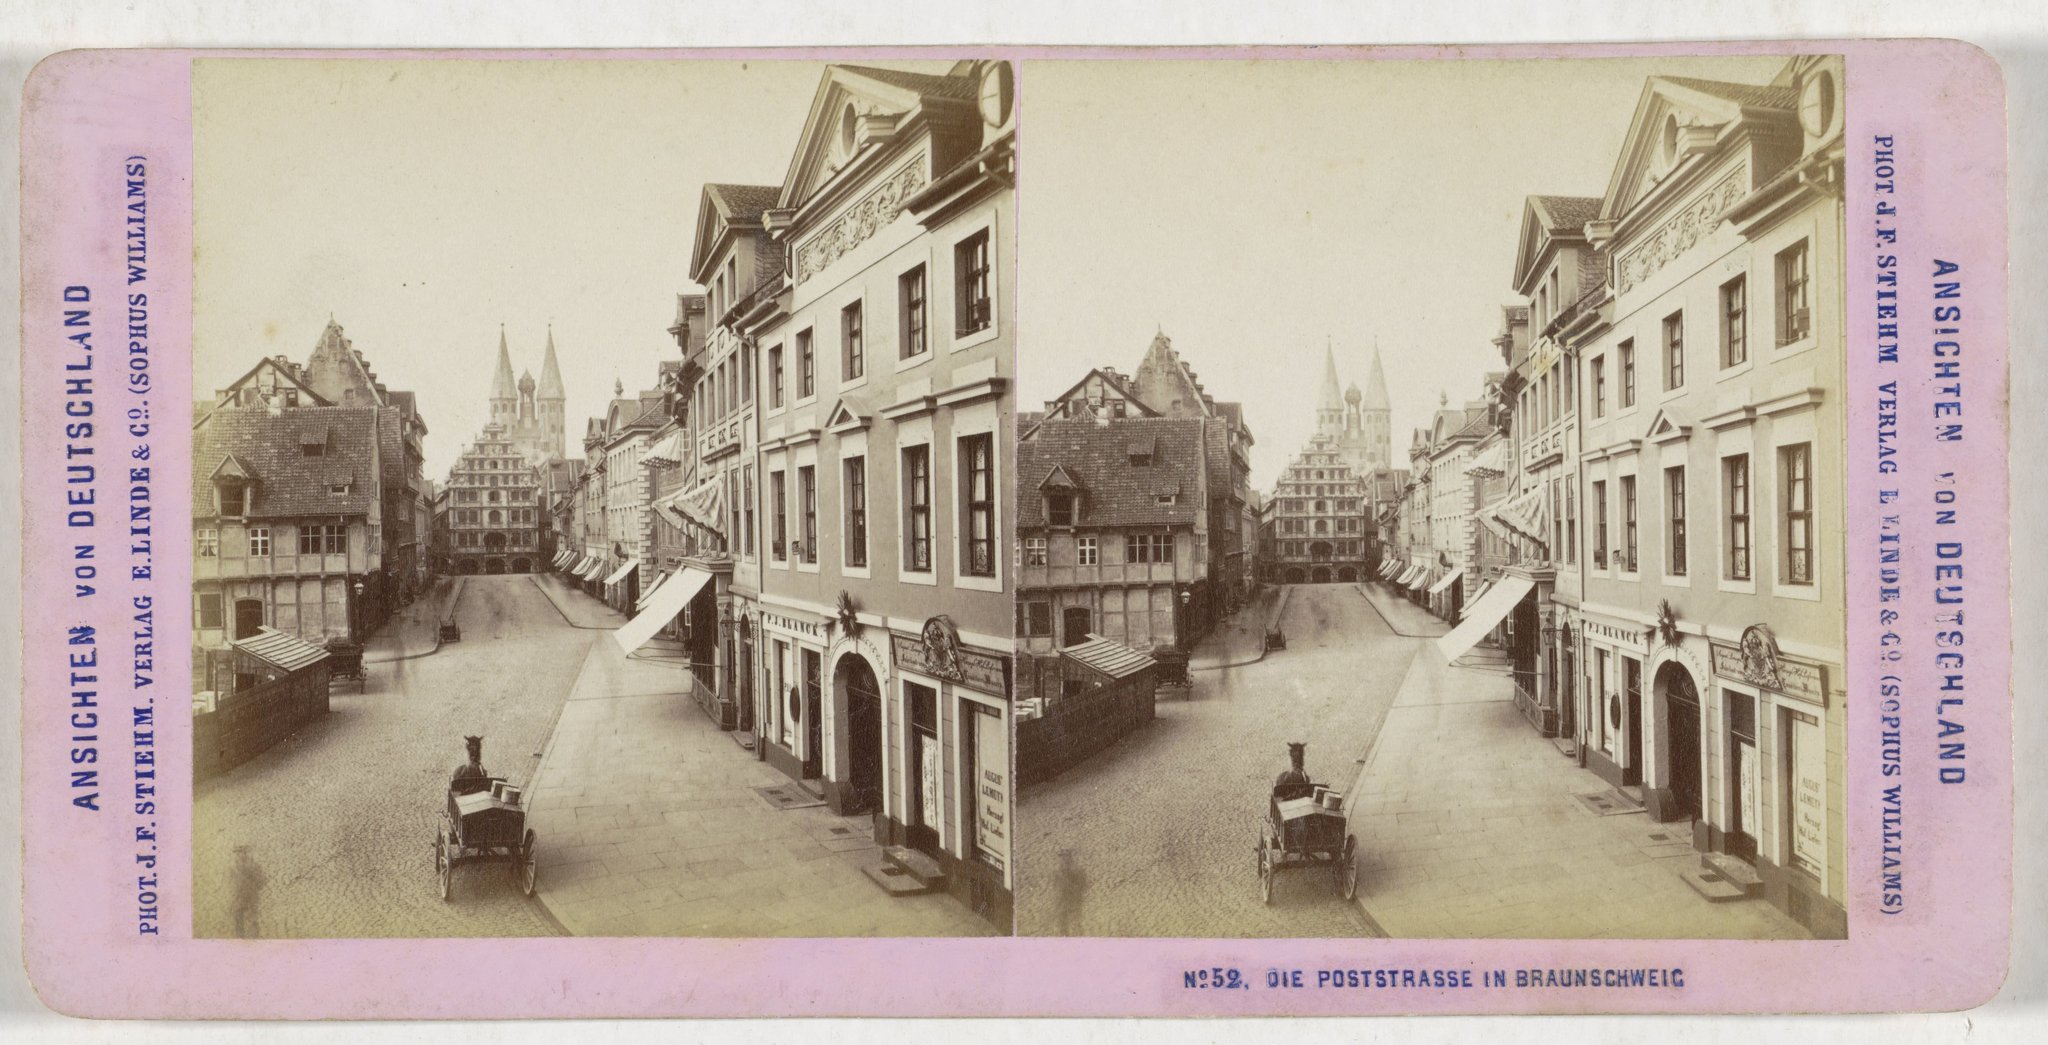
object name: stereograph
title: Ansichten von Deutschland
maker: johann friedrich stiehm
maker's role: fotograaf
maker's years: 1826-1902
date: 1869-1872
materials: cardboard, paper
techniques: albumen print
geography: braunschweig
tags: street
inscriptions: number: ‘No 52.’